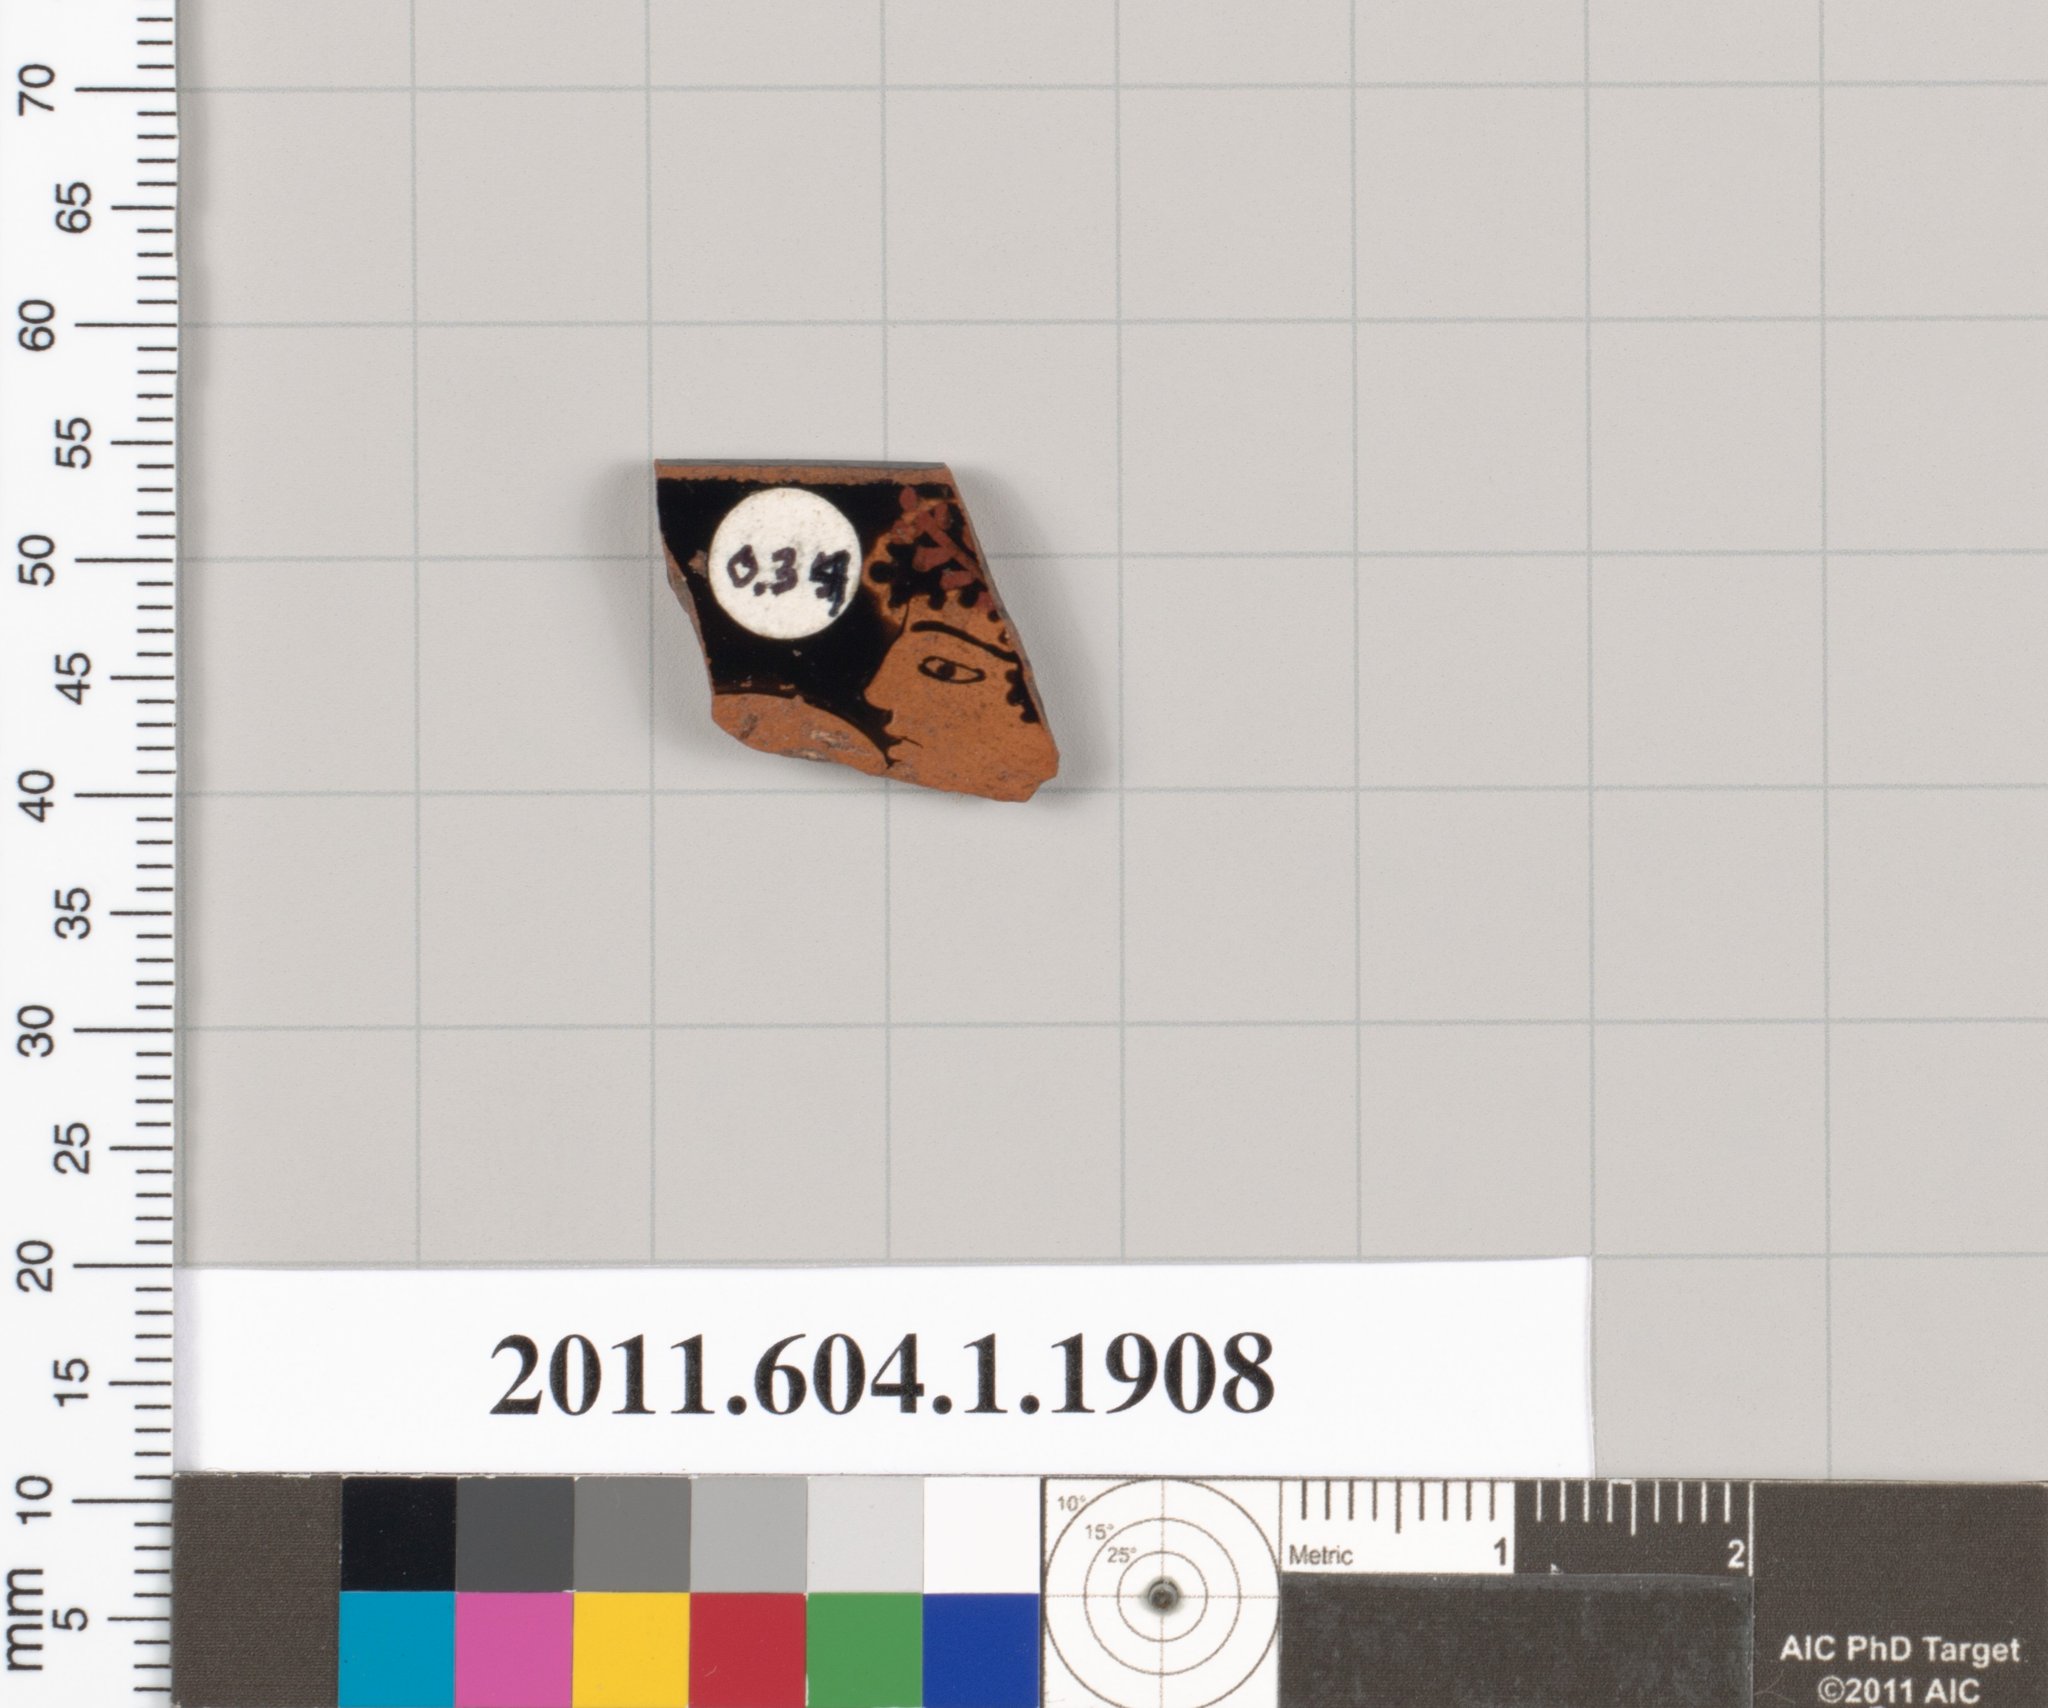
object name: kylix fragment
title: Terracotta rim fragment of a kylix (drinking cup)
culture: greek, attic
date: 534-468 BCE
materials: terracotta